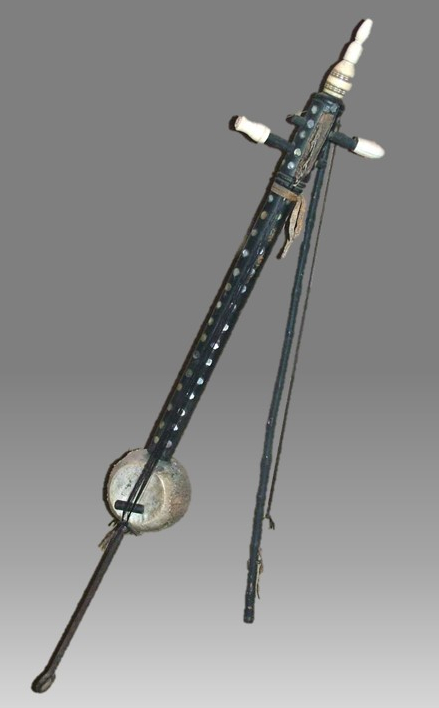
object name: rabāb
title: Rabāba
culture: egyptian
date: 1867-1900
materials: plant material, wood, hair, iron, pearl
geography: egypt